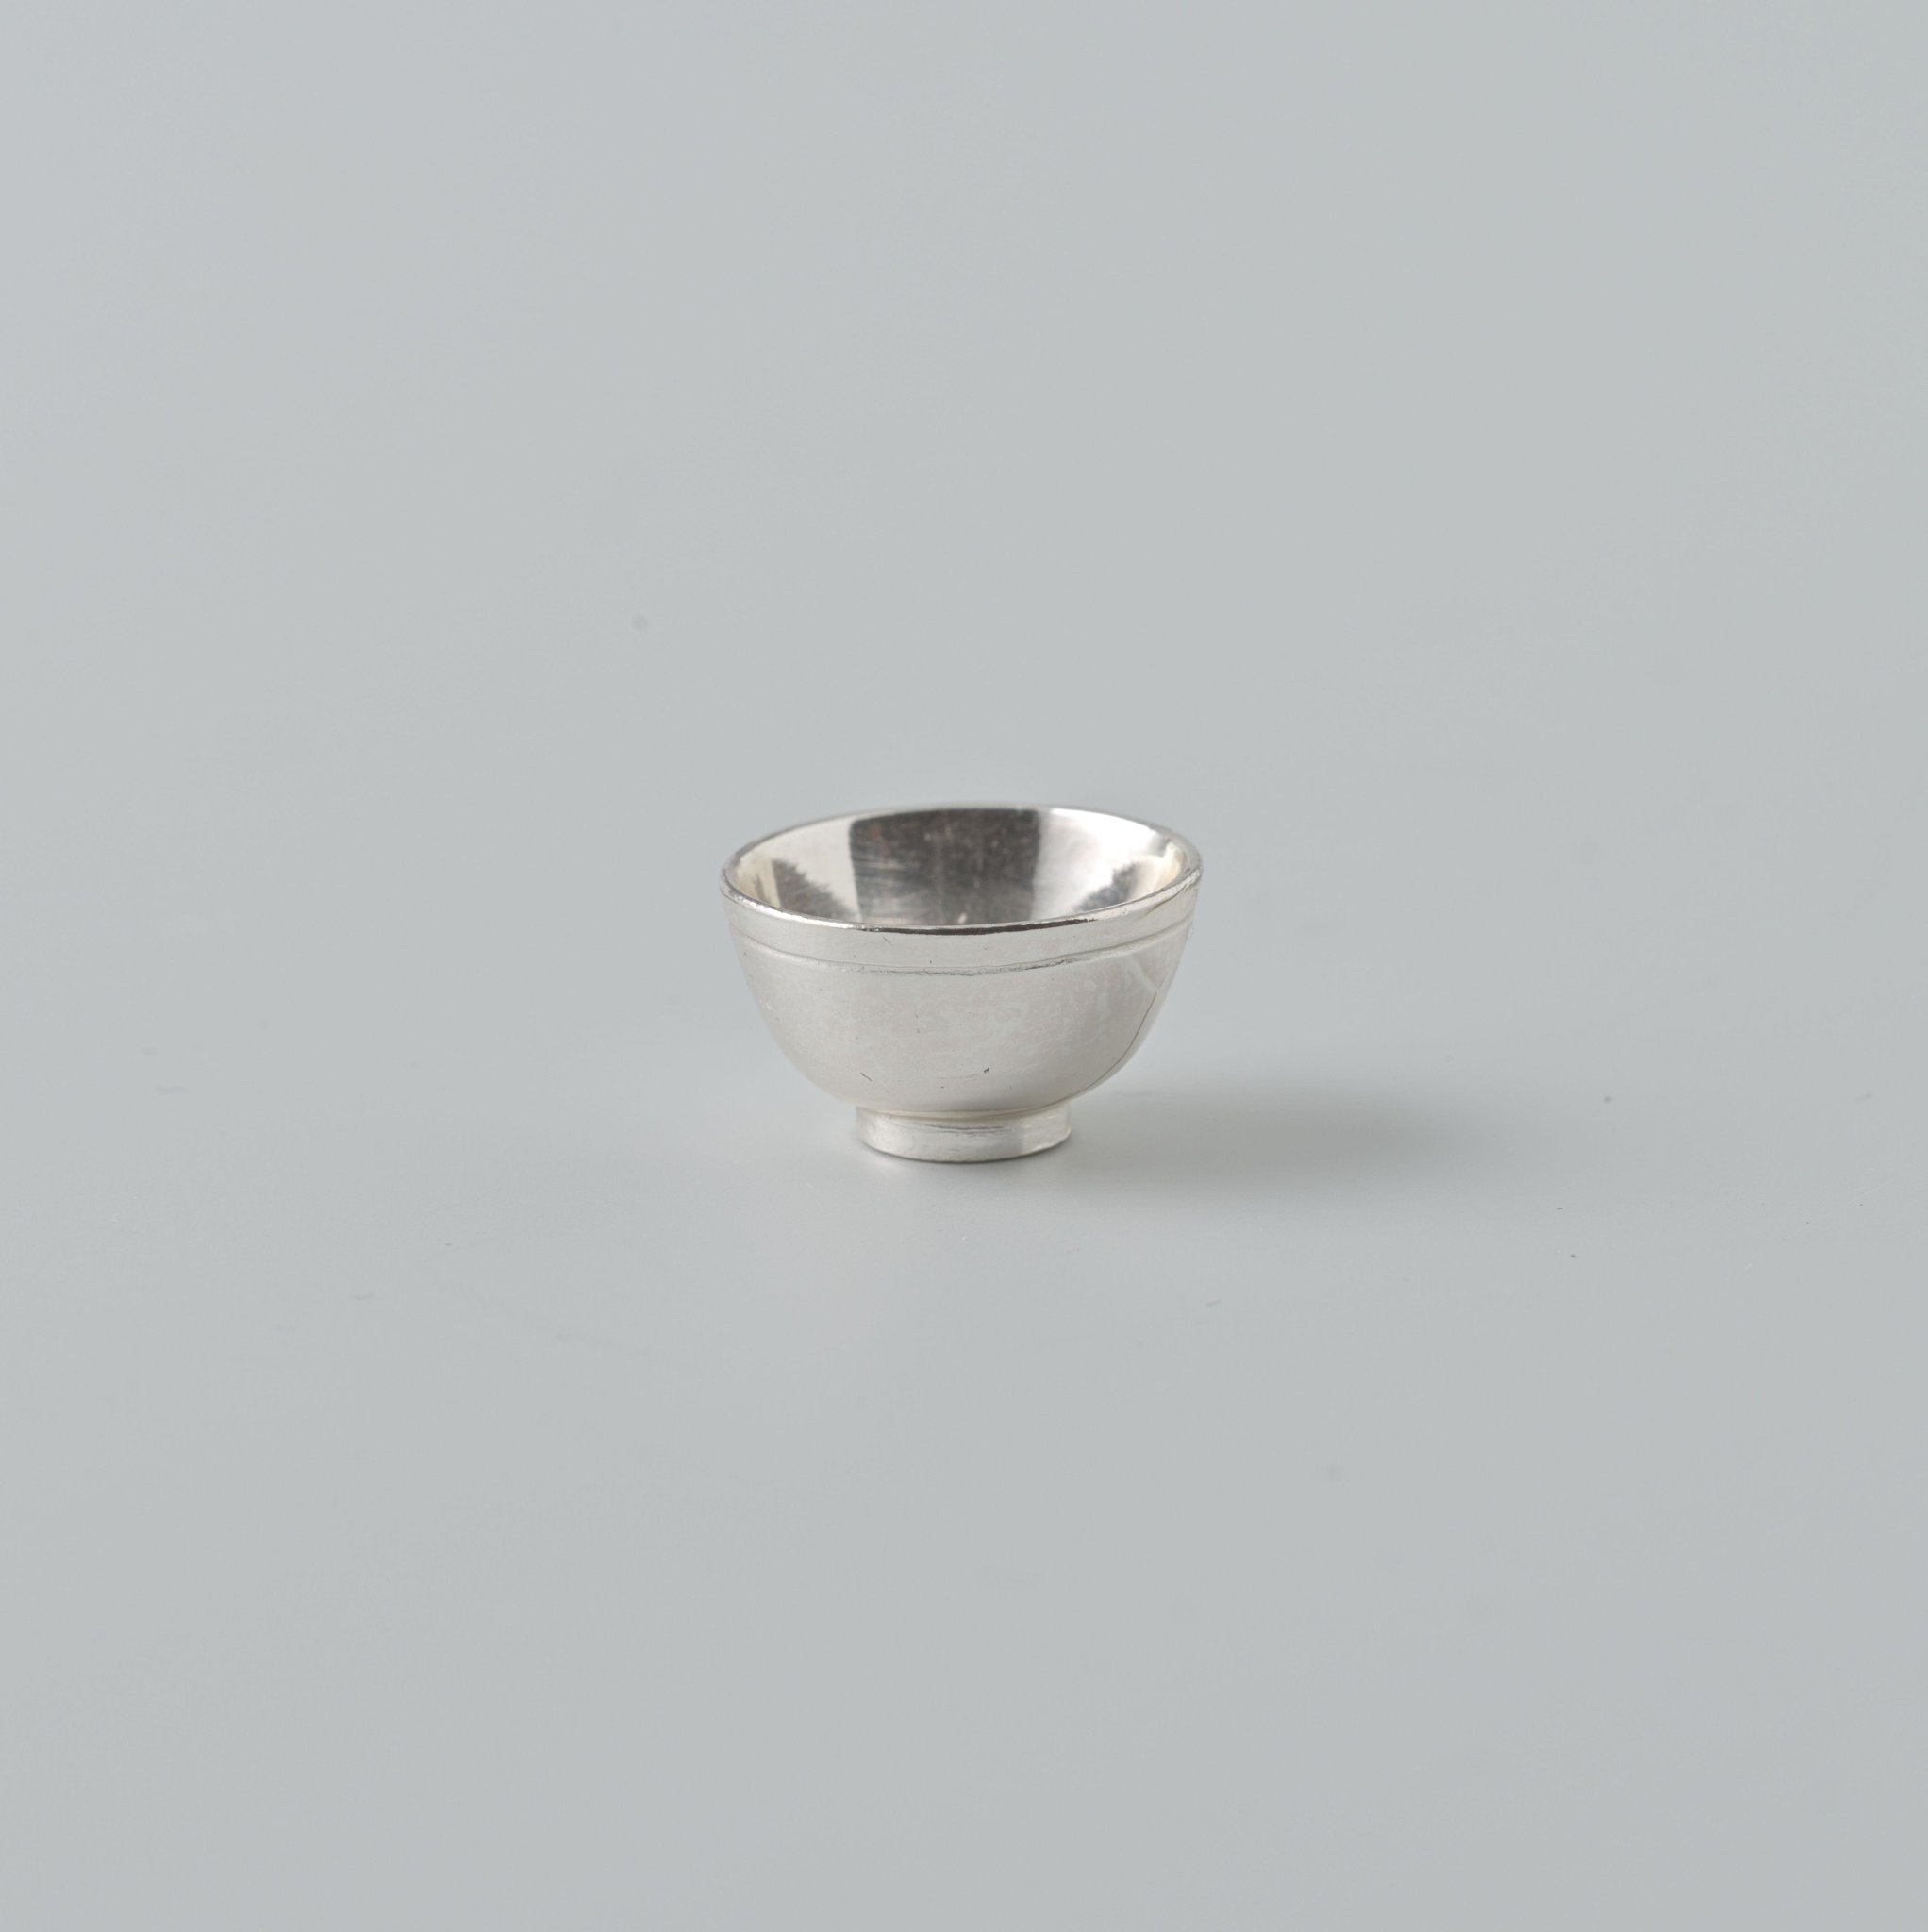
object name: miniature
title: Miniatuur kom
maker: Anonymous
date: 1765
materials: silver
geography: amsterdam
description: Kom van zilver, met bijbehorende schotel (L). Kom glad met groefrand, op standring. Gemerkt: stadsteken Amsterdam; jaarletter F.